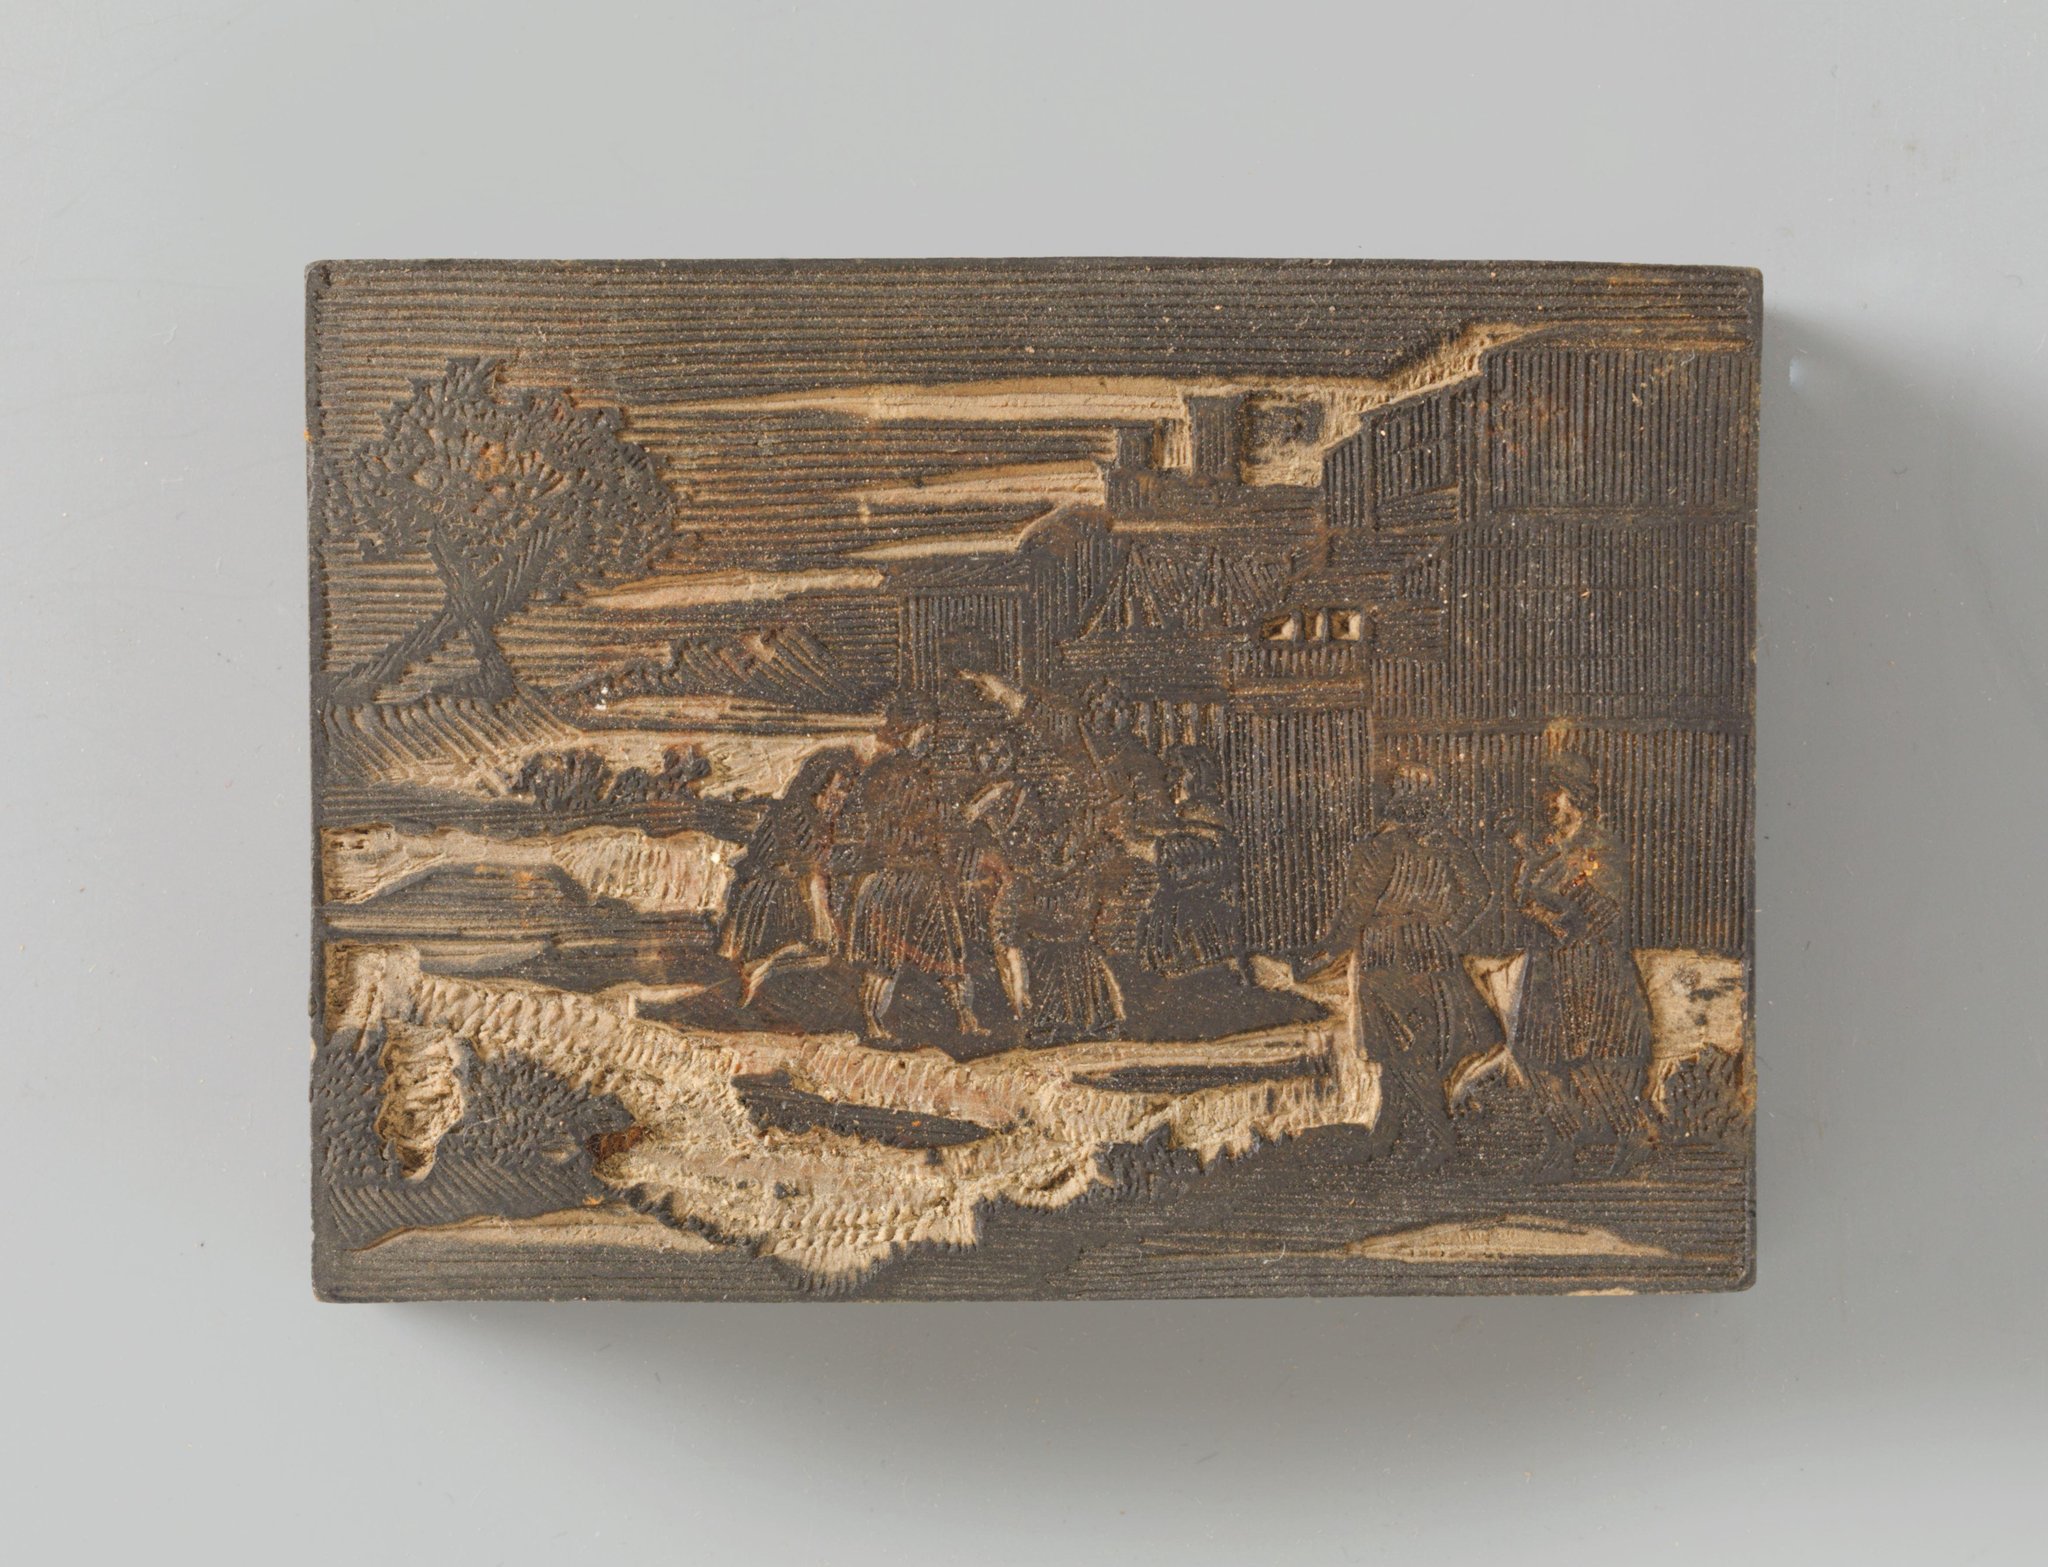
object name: wood block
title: Bijbel-illustraties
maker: Anonymous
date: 1550-1699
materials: wood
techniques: woodcut